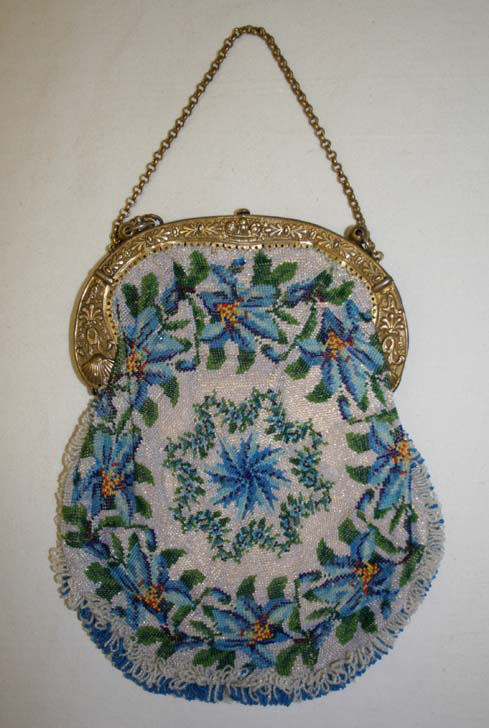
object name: bag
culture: french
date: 1820-1830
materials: silver